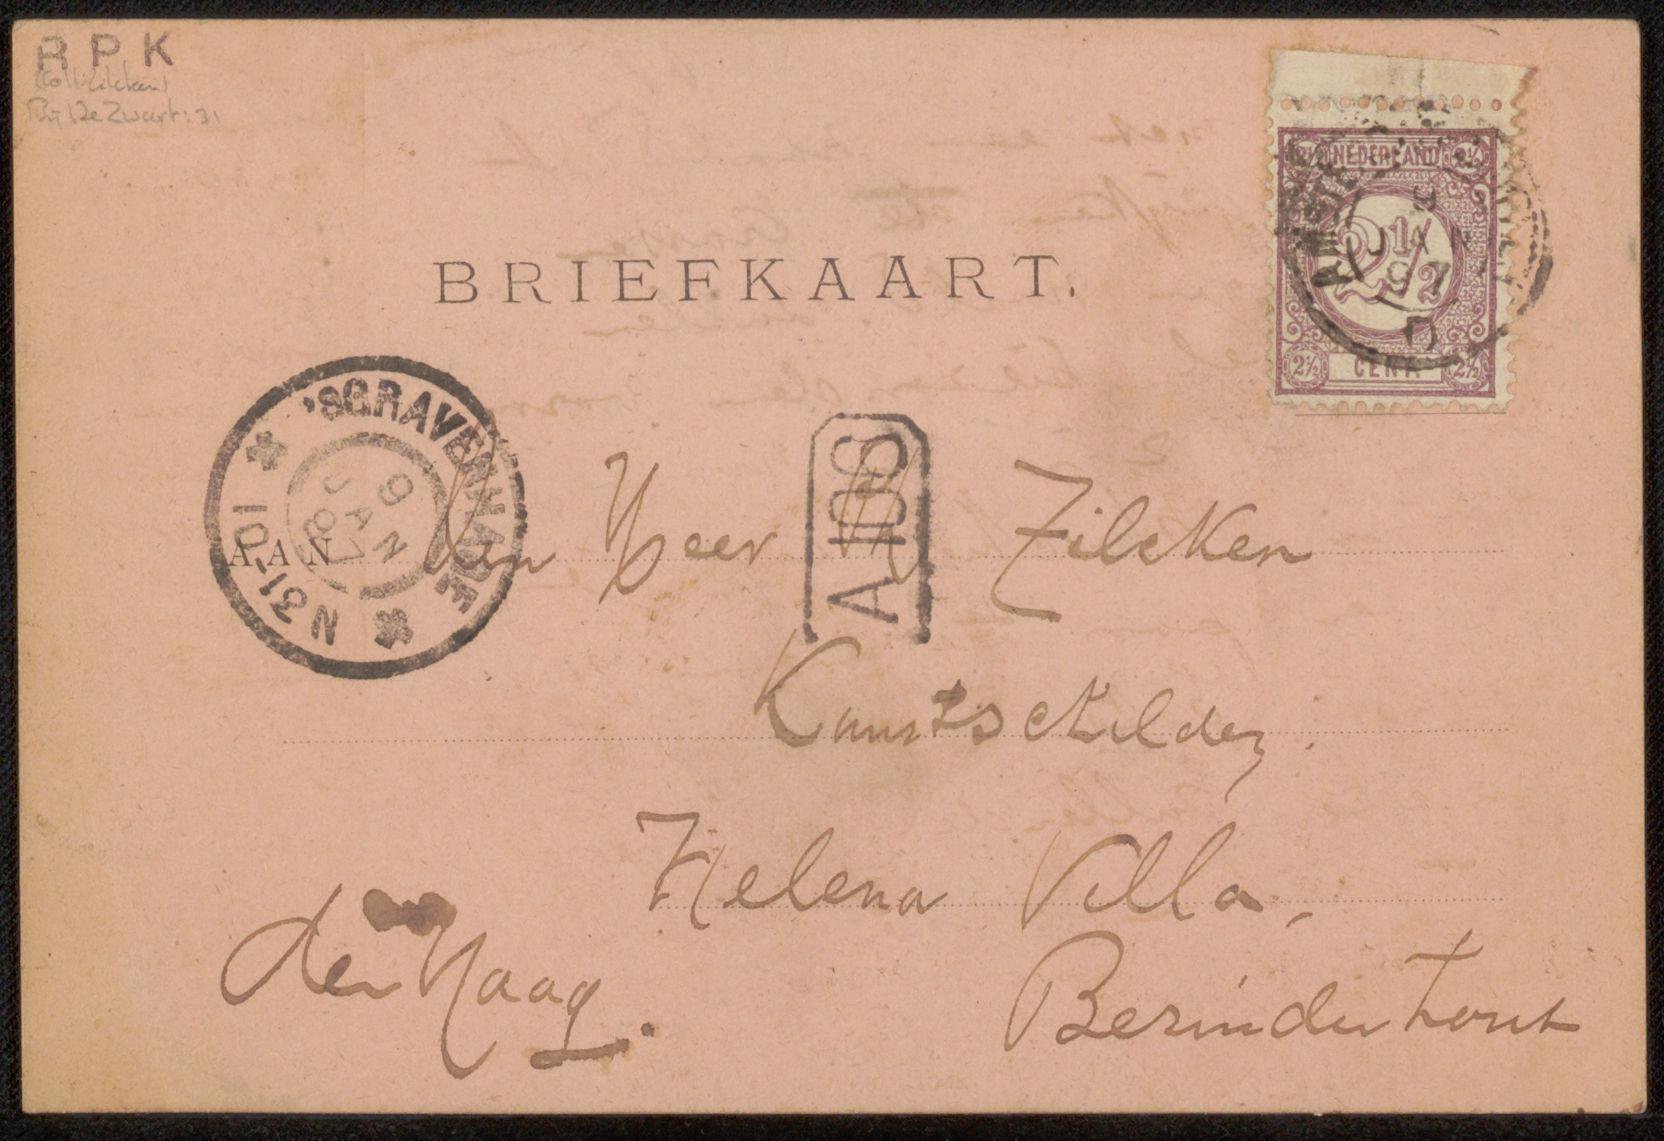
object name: postcard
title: Briefkaart aan Philip Zilcken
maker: willem de zwart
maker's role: draughtsman, painter, print maker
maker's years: 1862-1931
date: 1897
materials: cardboard, ink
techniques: pen, writing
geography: soest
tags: philip zilcken, the graphic arts, venice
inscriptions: collector's mark: ‘RPK’